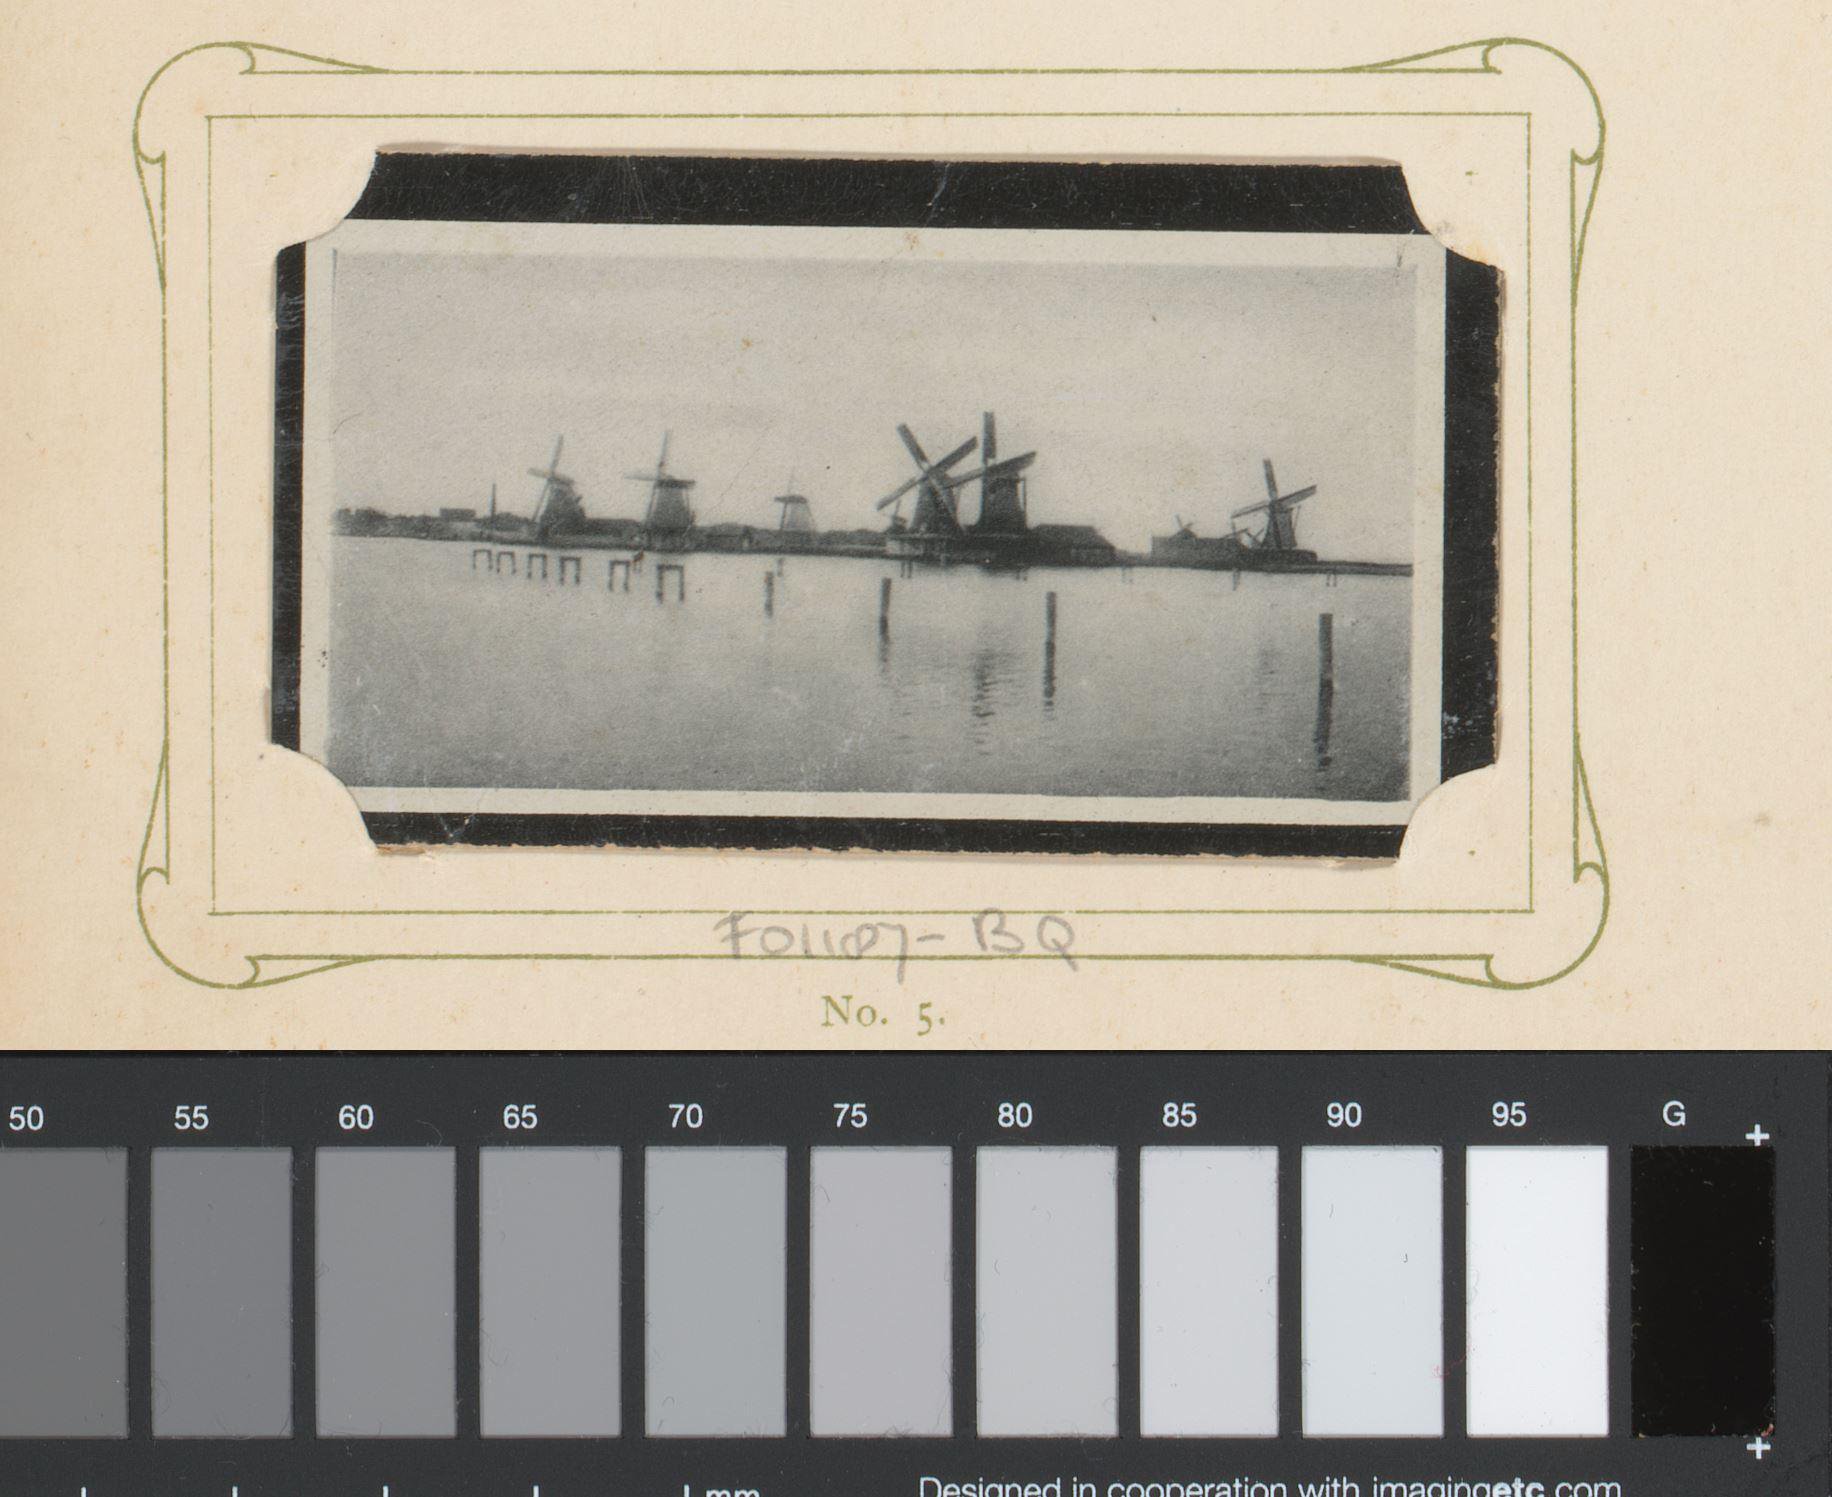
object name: photomechanical print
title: Gezicht op de Zaan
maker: Anonymous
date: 1905-1906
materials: paper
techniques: photograph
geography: zaan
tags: water course, windmill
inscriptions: inscription: ‘No. 5./ Zaangezicht.’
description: Deze prent maakt deel uit van een album.